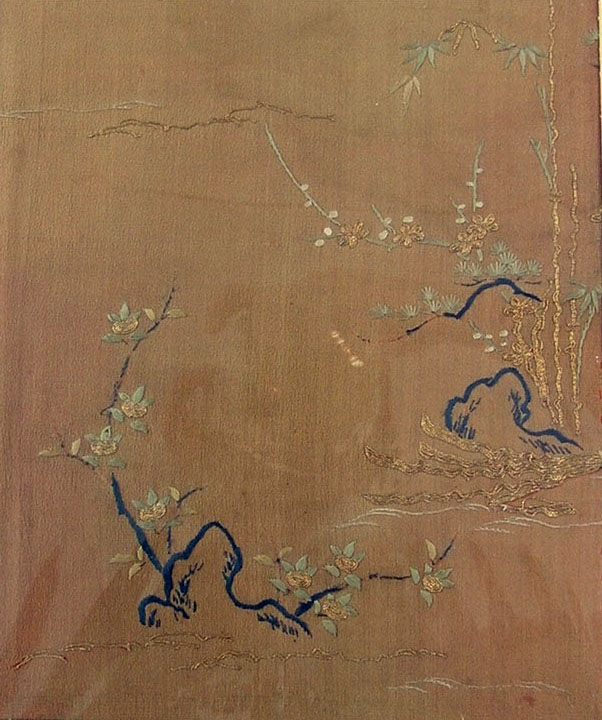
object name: piece from a kosode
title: Piece from a Kosode with Pine, Bamboo, Blossoming Plum, and Mandarin Orange Tree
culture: japanese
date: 1615-1868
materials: metal thread, silk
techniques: embroidery, weave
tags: flowers,bamboo